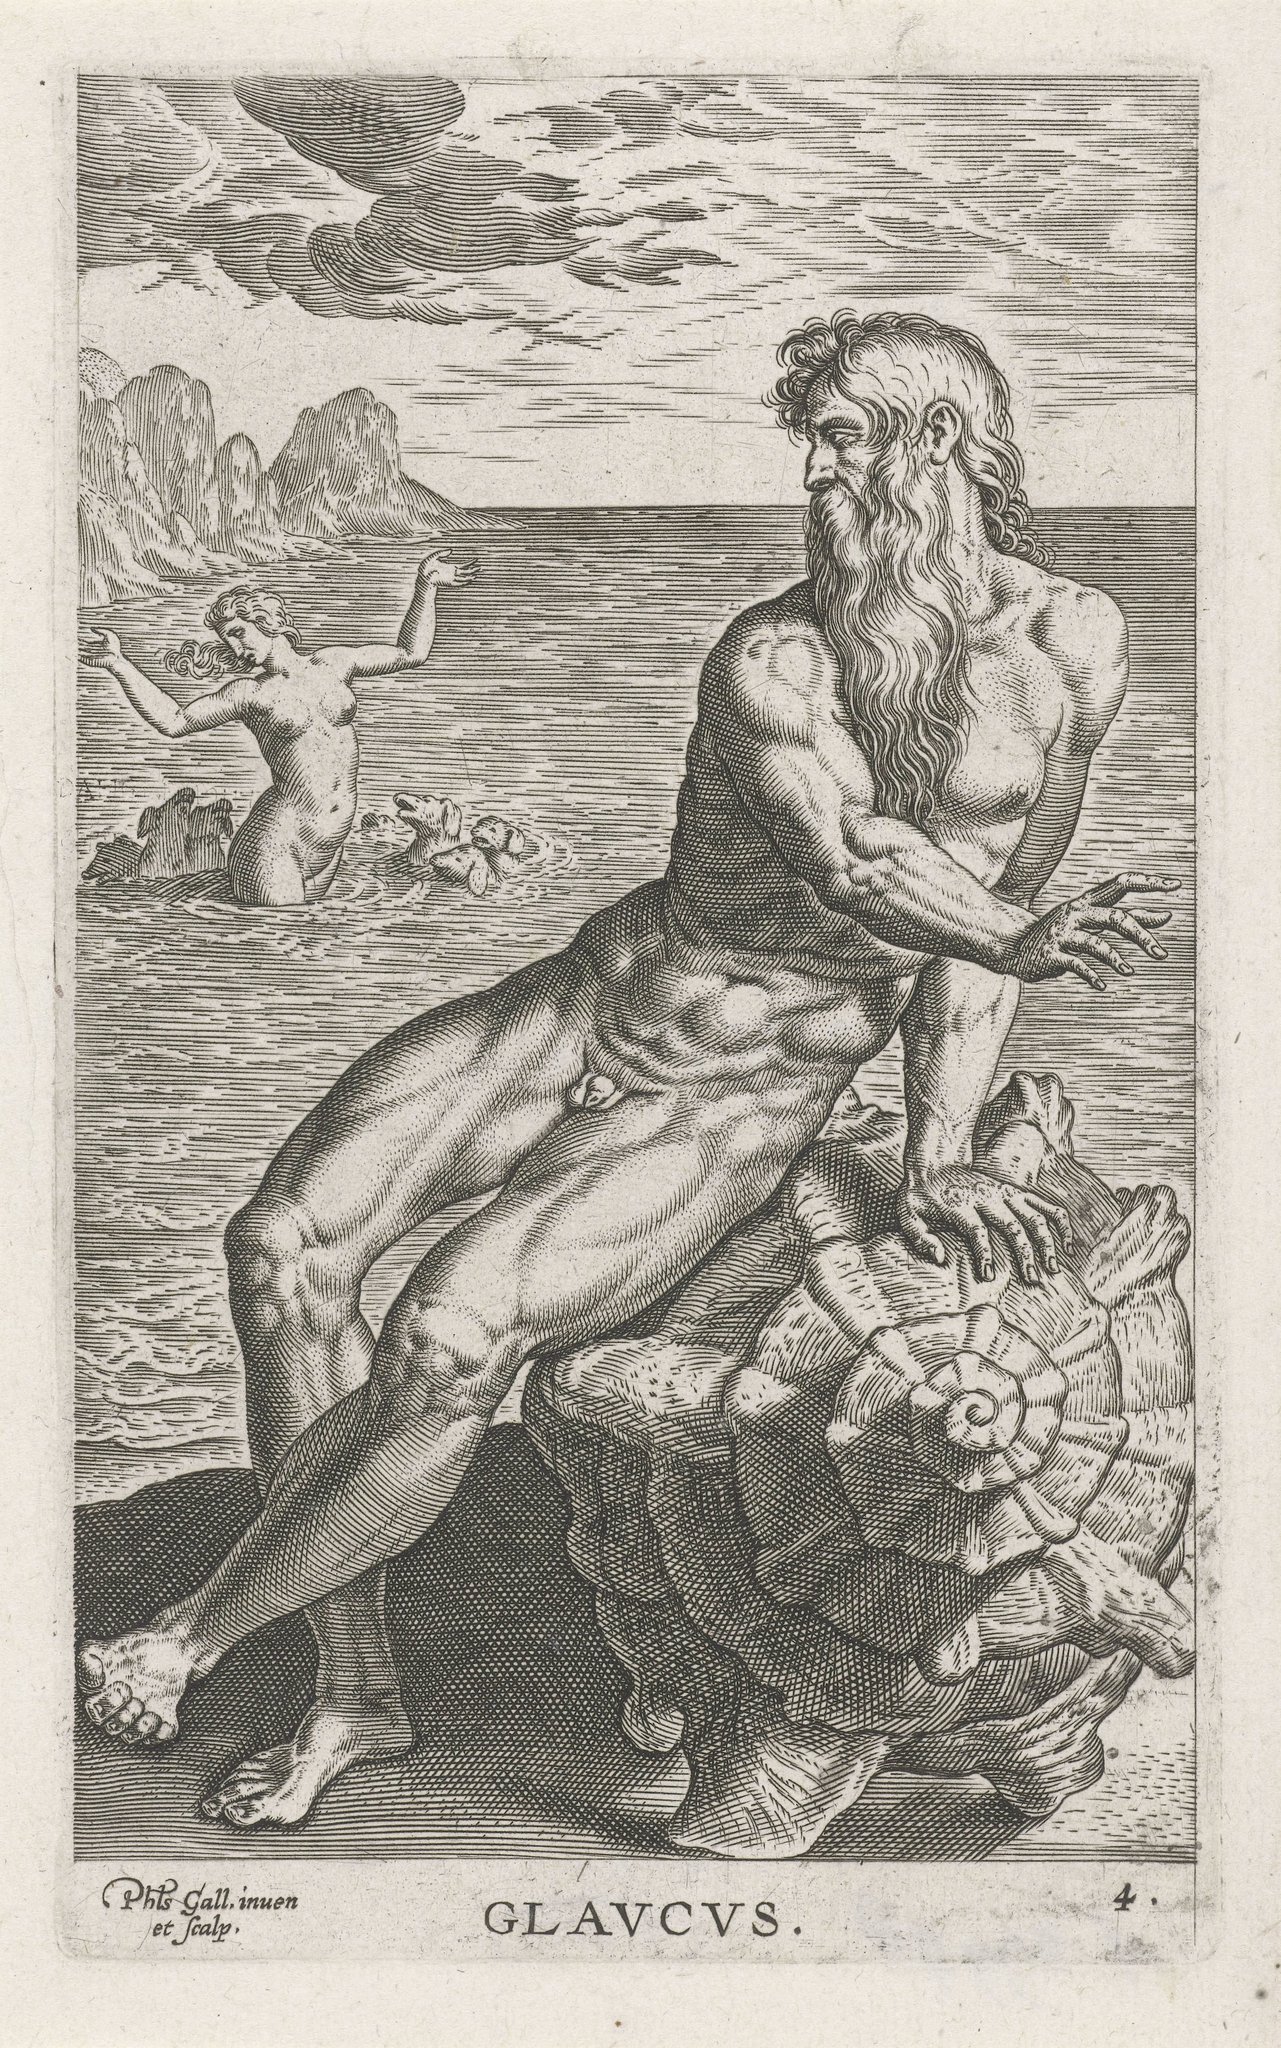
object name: print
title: Zeegod Glaucus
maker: philips galle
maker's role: print maker, publisher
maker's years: 1537-1612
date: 1586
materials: paper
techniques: engraving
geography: antwerp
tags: (story of) glaucus, the fisherman, who was made a sea-god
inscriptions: collector's mark: Lugt 2228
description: De zeegod Glaucus, gezeten op een schelp. In de achtergrond de nimf Scylla. De prent maakt deel uit van een zeventiendelige serie over rivier- en zeegoden.